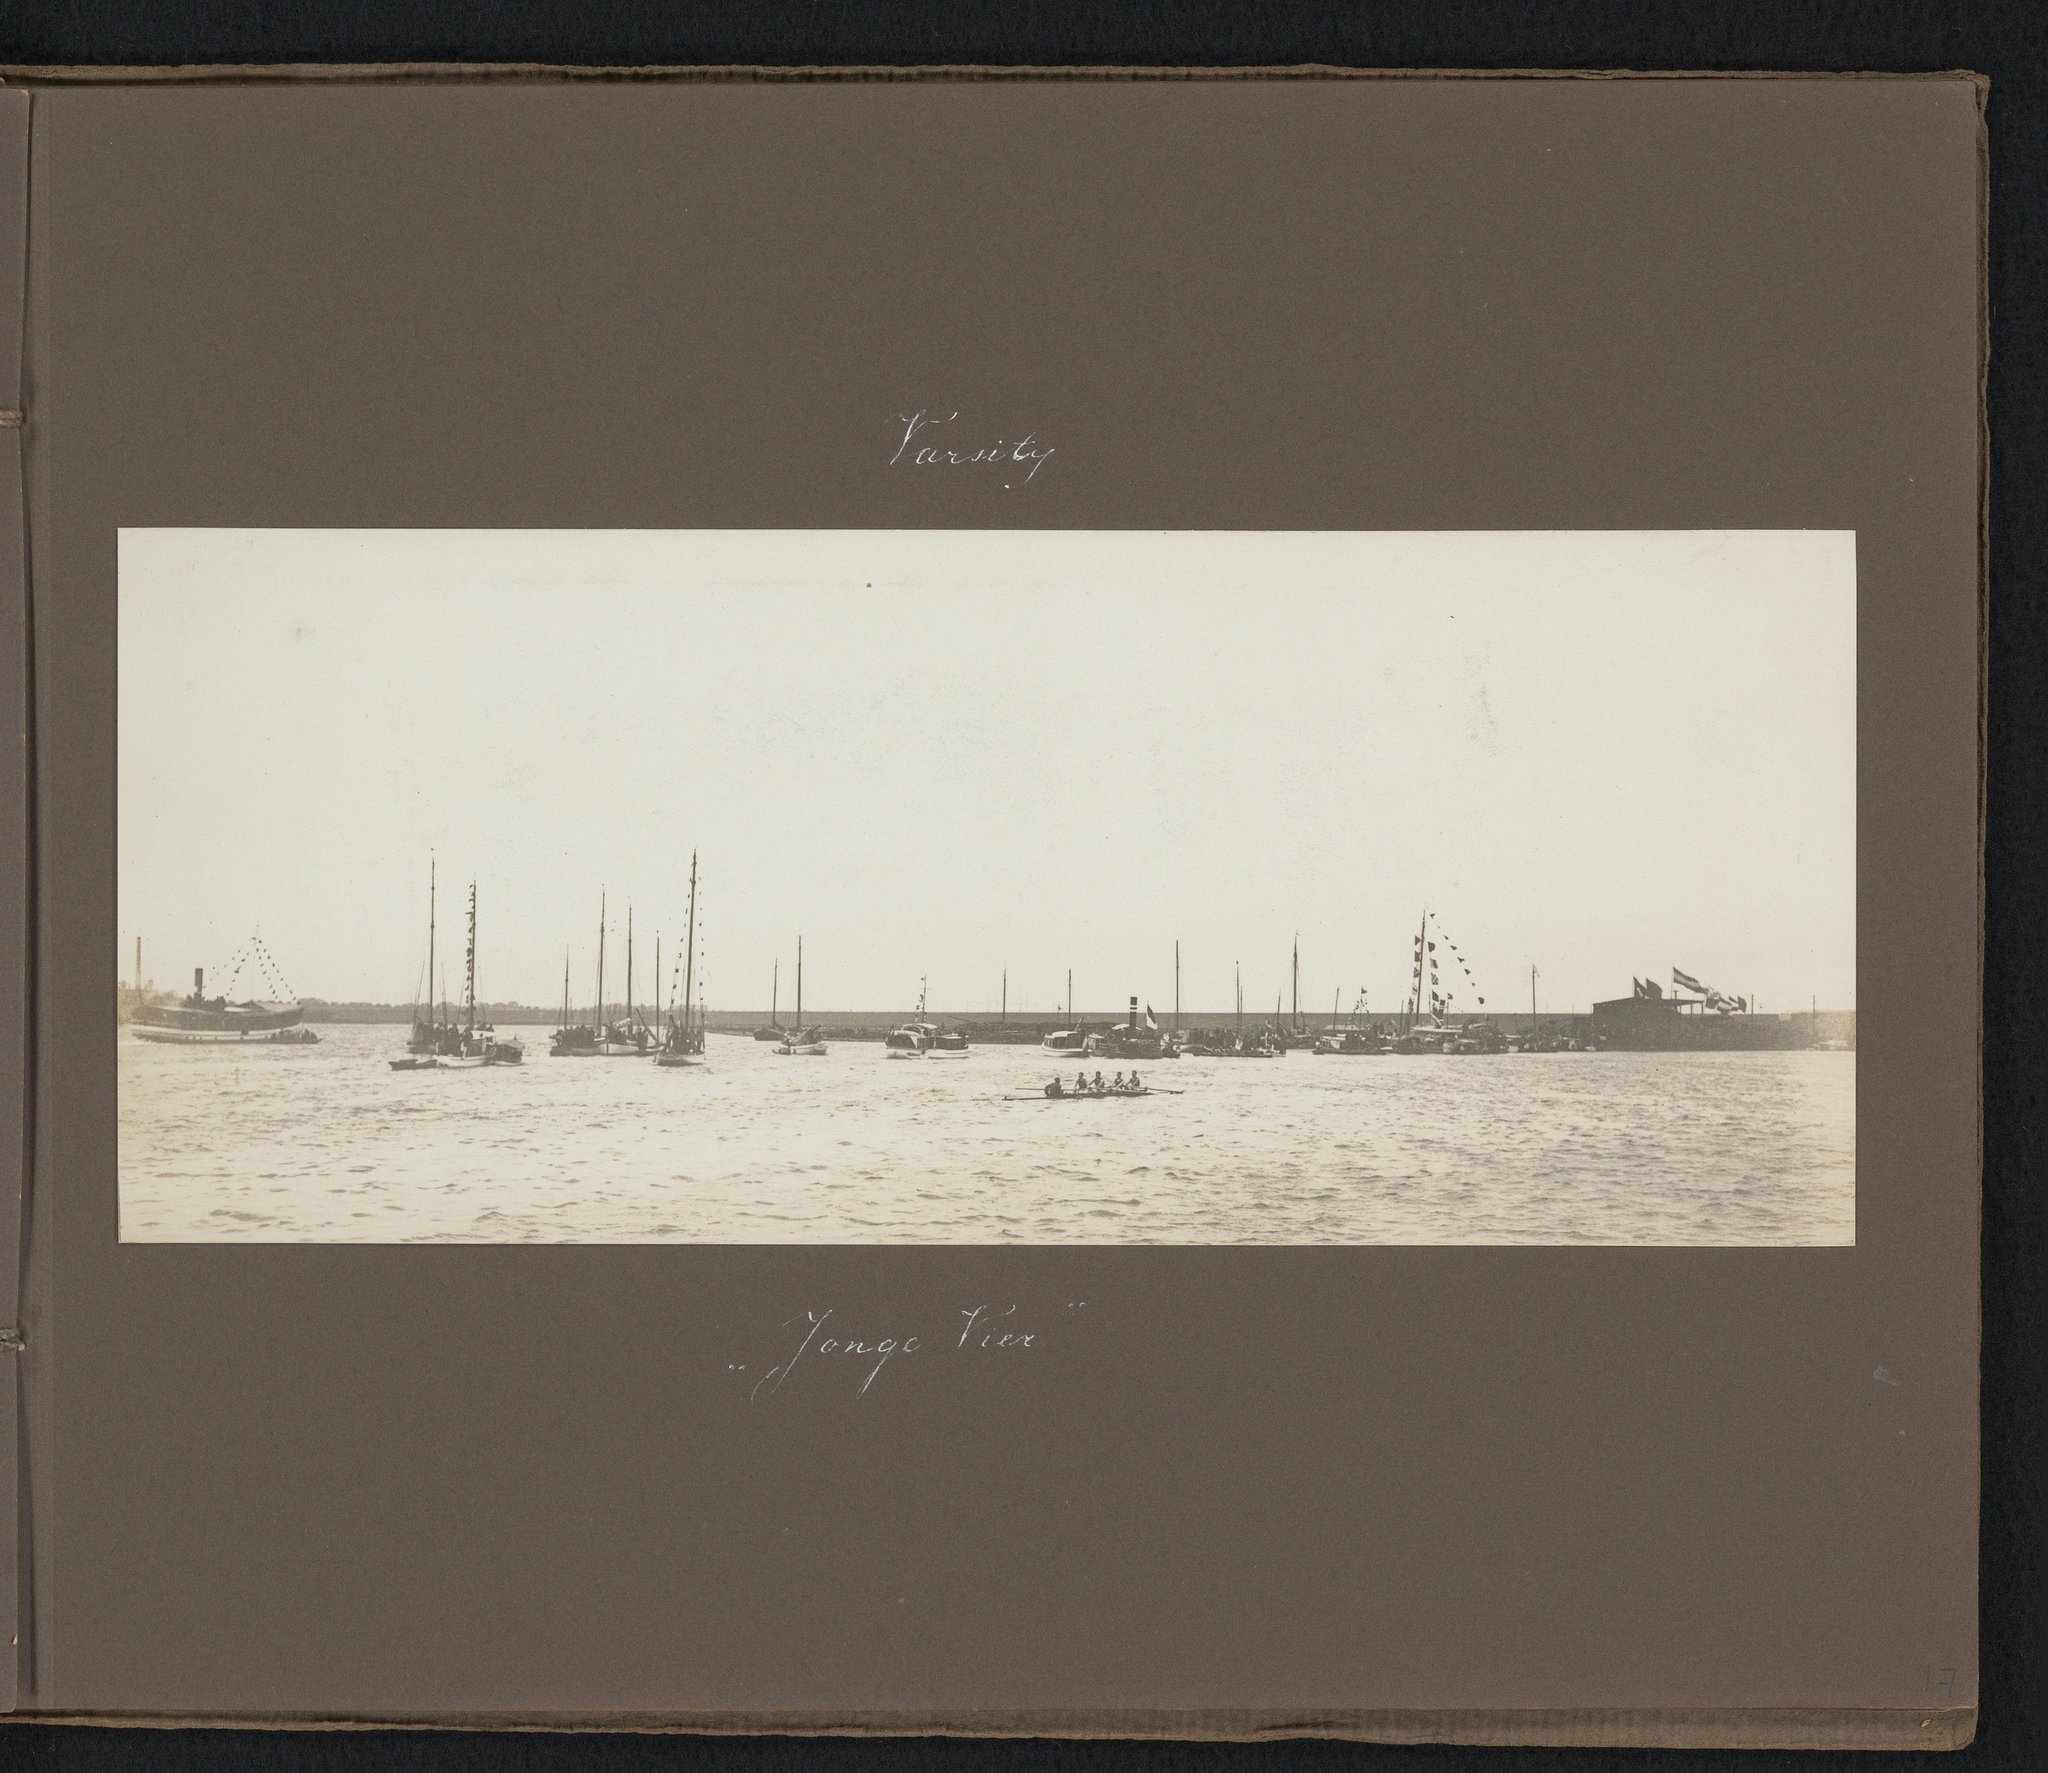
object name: photograph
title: Jonge Vier in actie tijdens de Varsity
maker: Anonymous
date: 1915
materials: paper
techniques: gelatin silver print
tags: rowing facing backward, pulling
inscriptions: caption: ‘"Jonge Vier"’